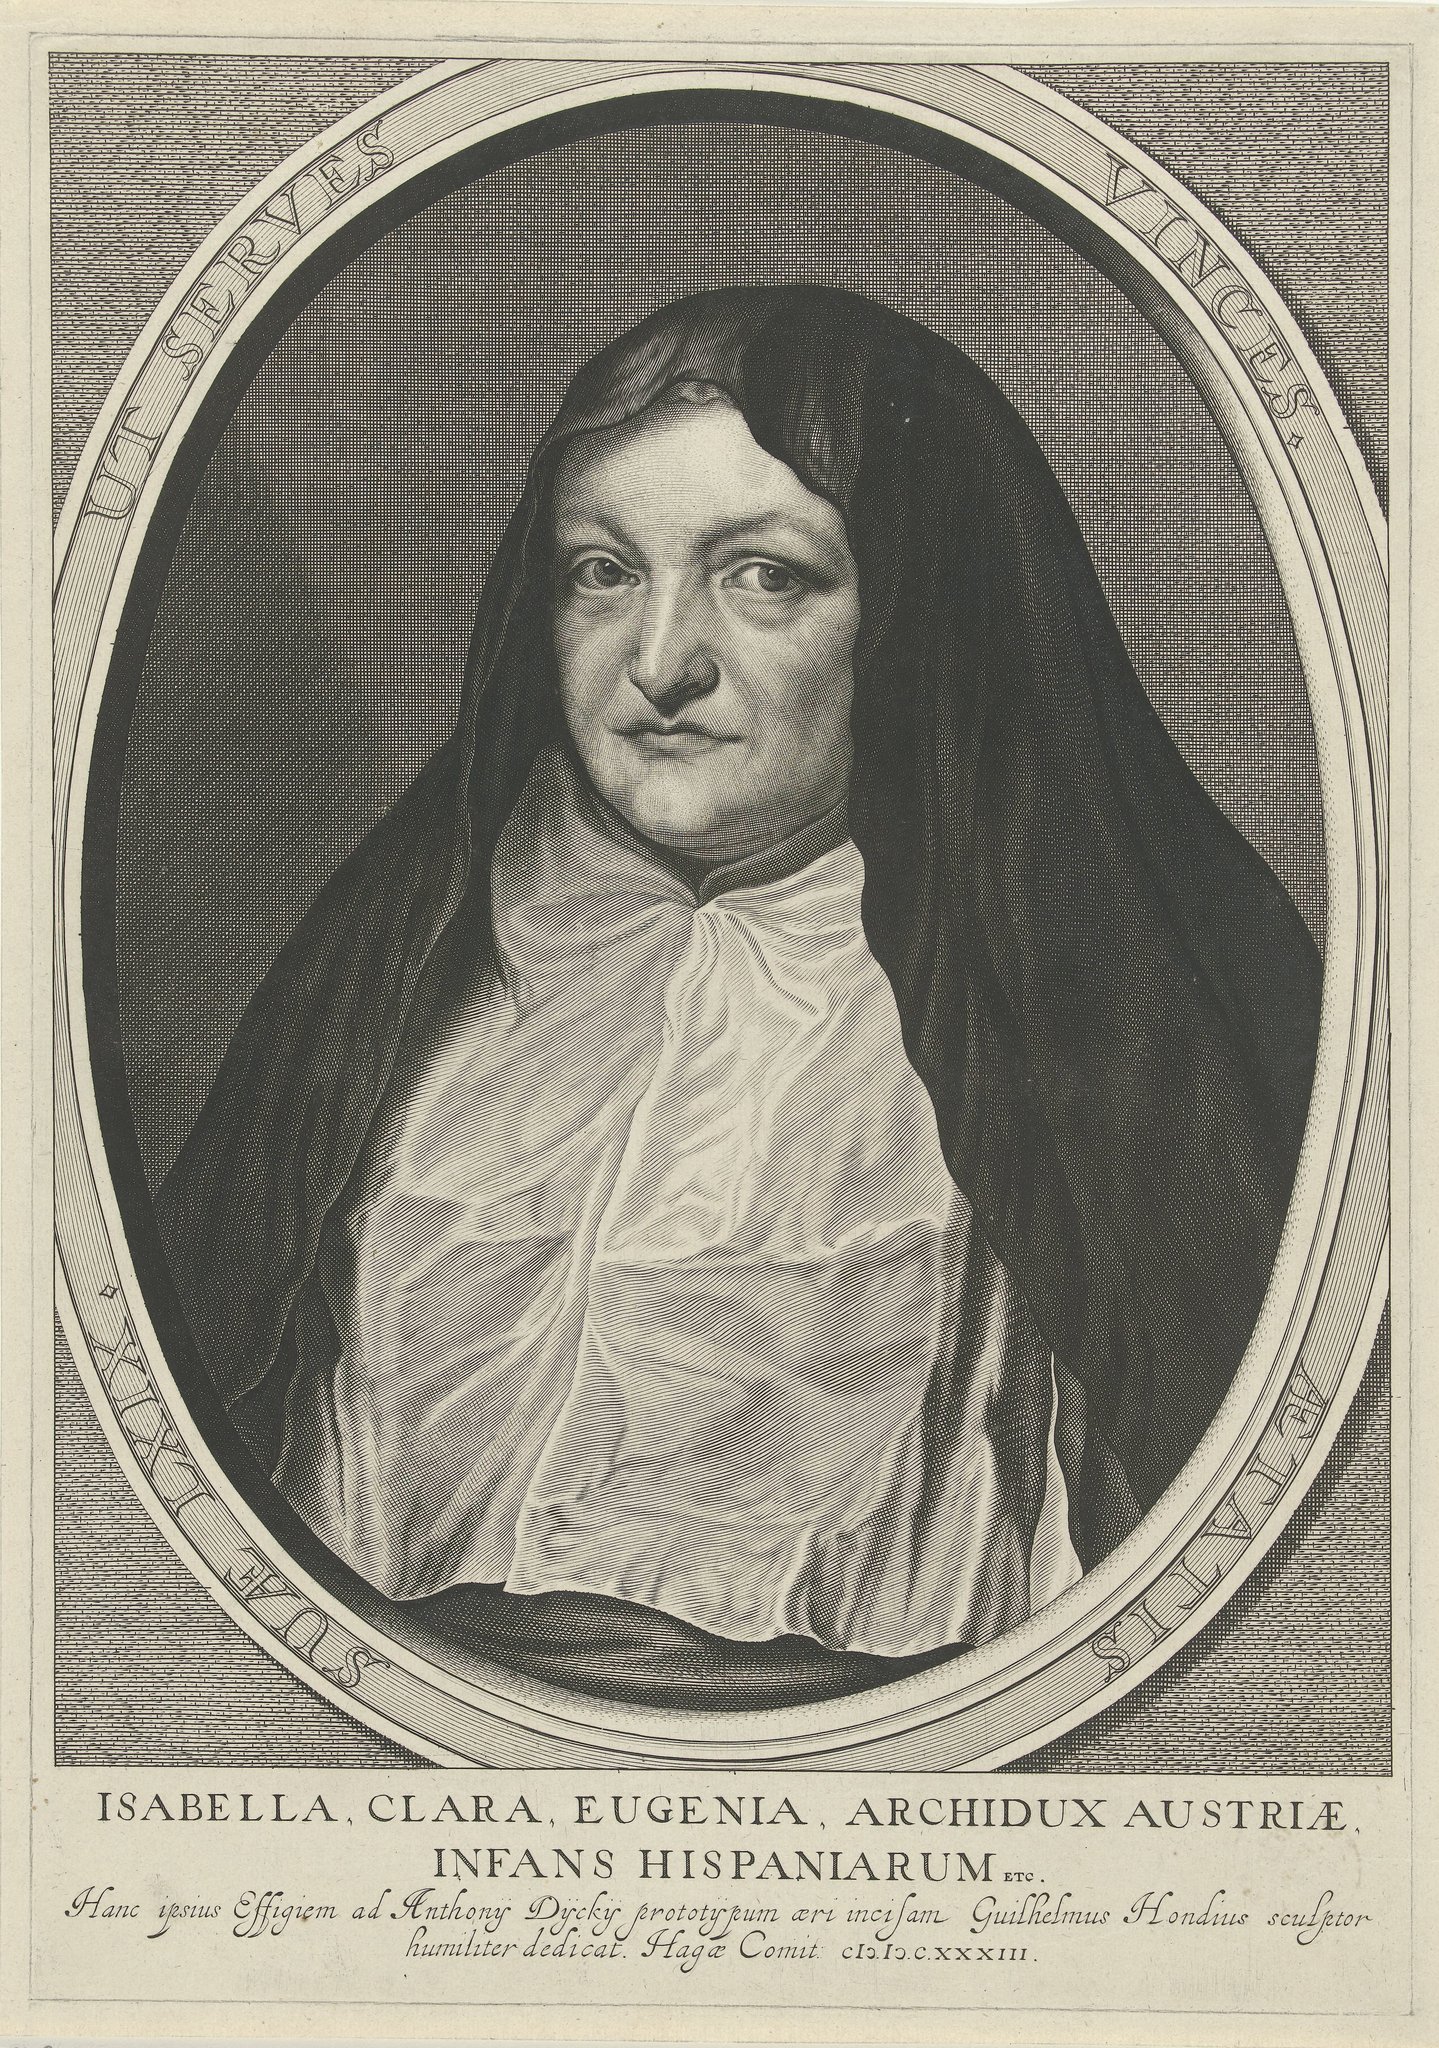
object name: print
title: Portret van Isabella Clara Eugenia, infante van Spanje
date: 1633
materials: paper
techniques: engraving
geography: the hague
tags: infante van spanje isabella clara eugenia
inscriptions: collector's mark: Lugt 2228, collector's mark: Lugt 240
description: Buste naar linkts van Isabella Clara Eugenia, infante van Spanje in een ovale omlijsting met randschrift in het Latijn. Onder het portret twee regels in het Latijn.